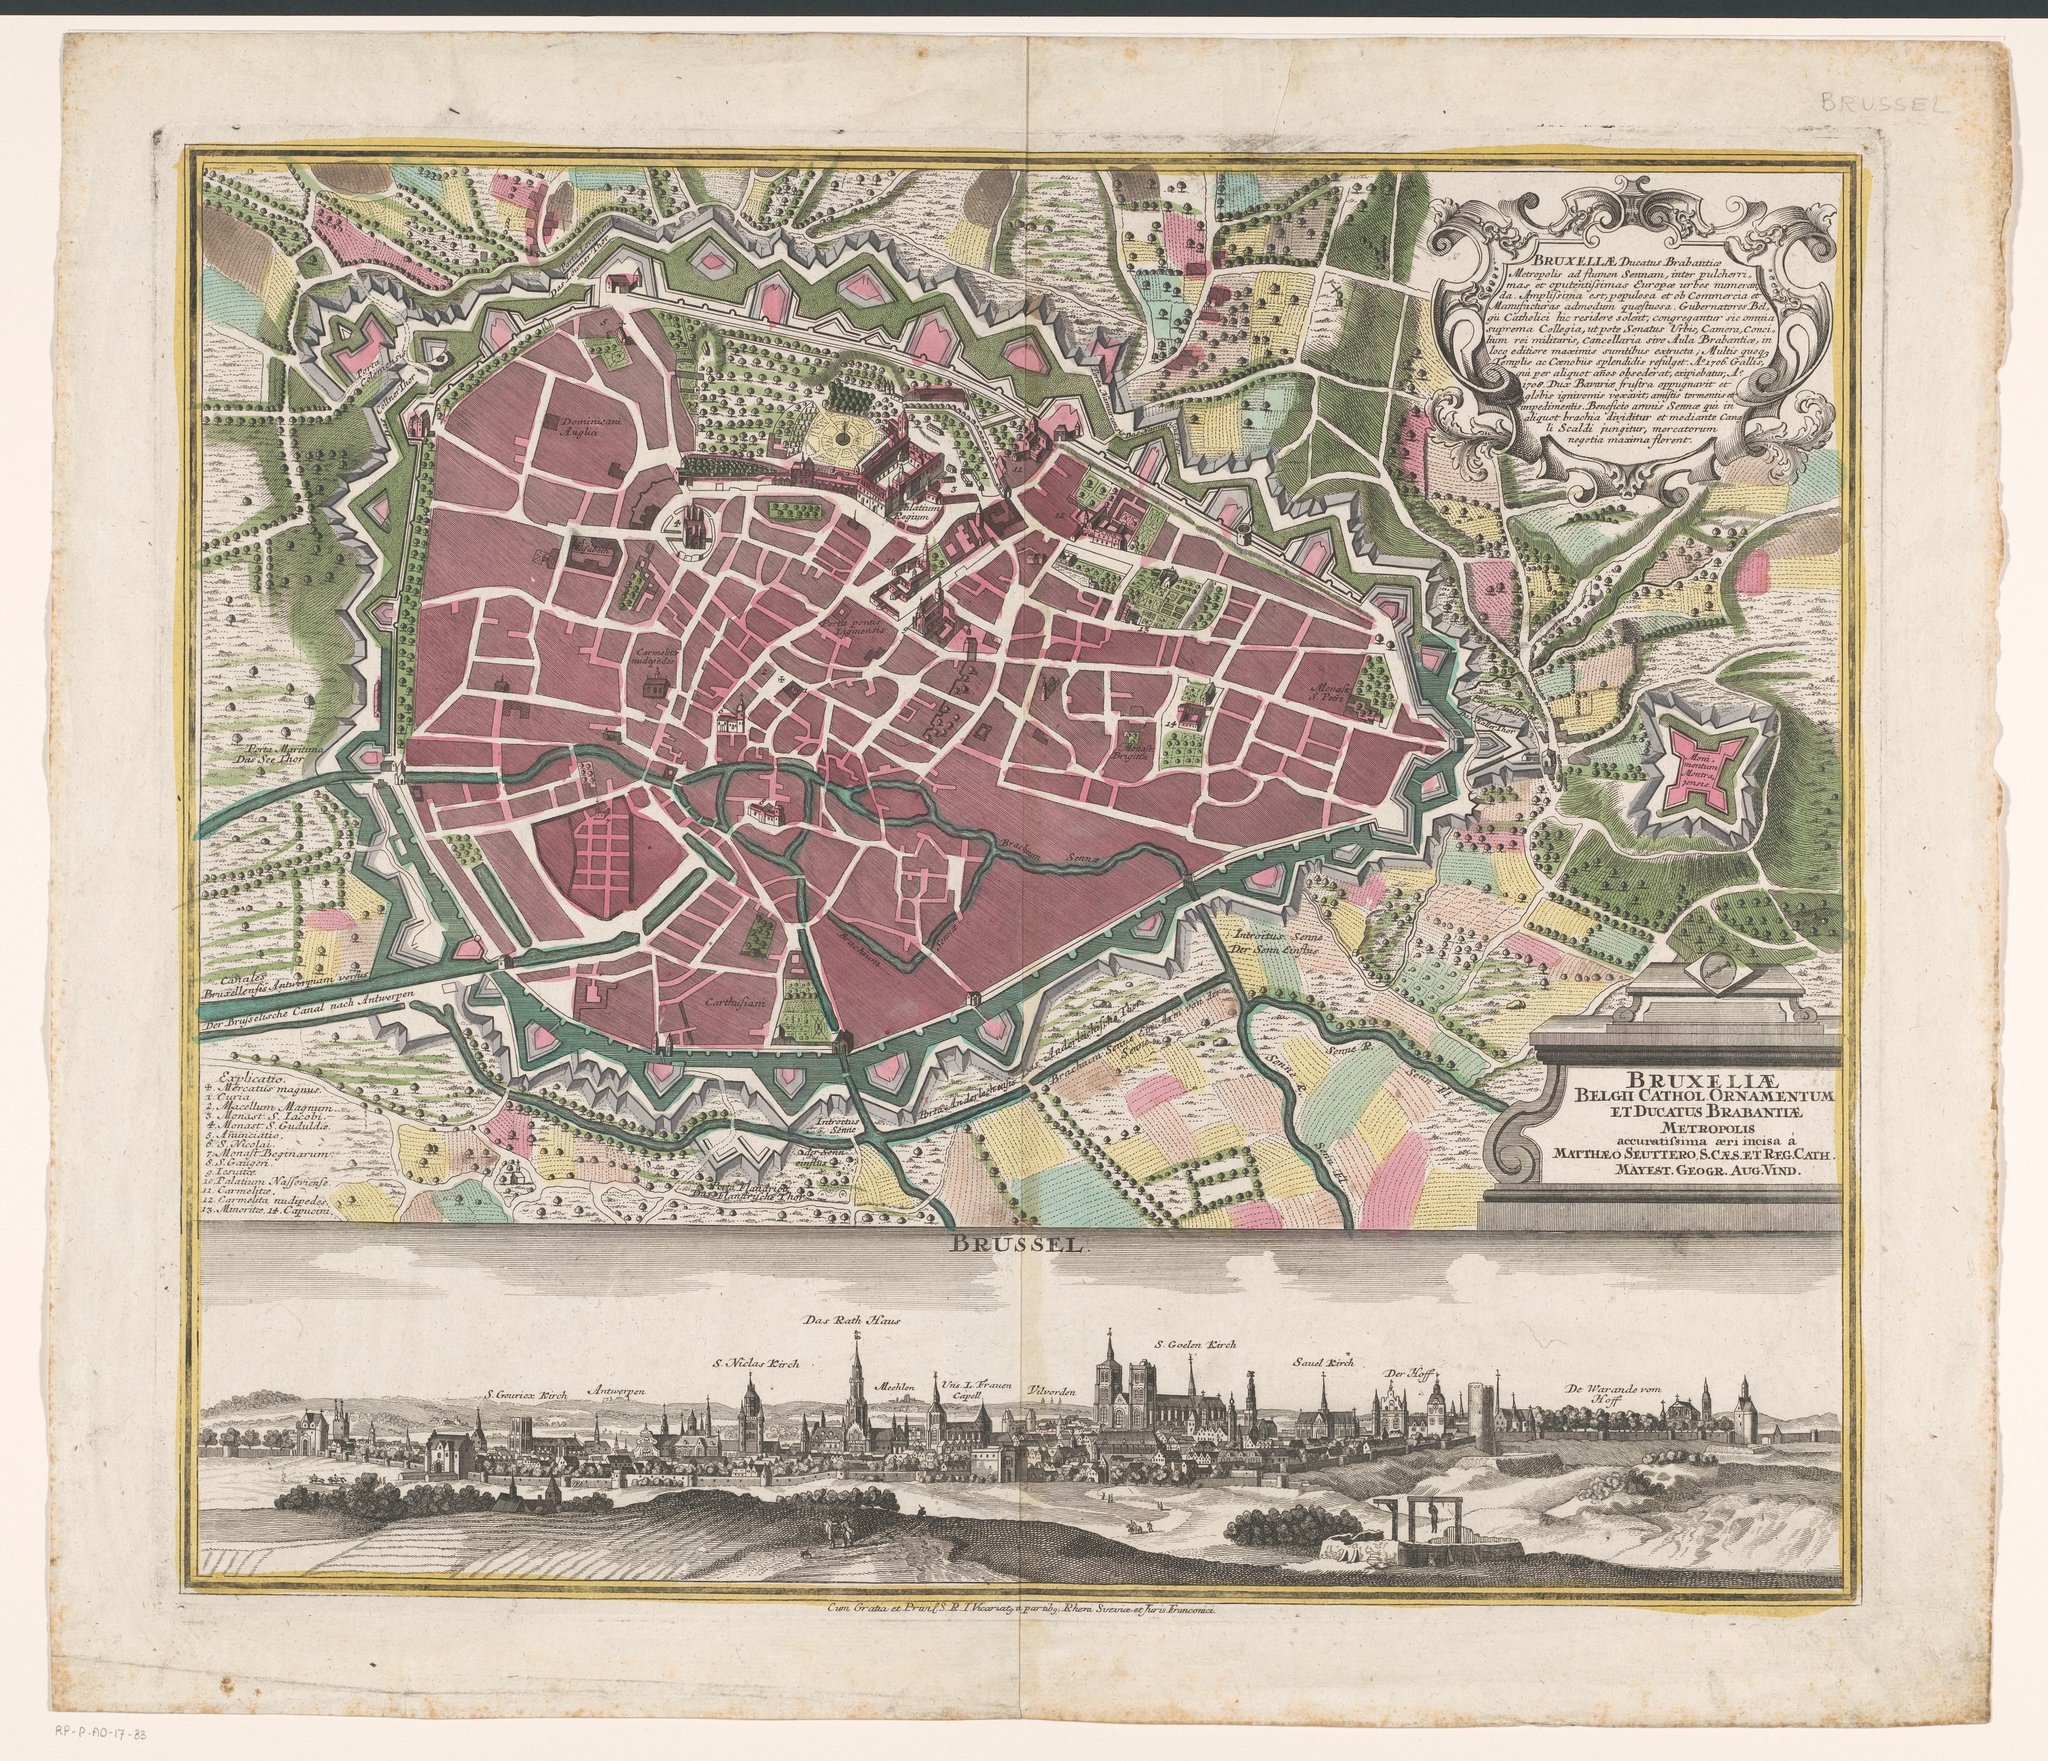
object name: area plan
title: Plattegrond van Brussel met stadsgezicht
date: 1708-1757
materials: paper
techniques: engraving, etching, hand coloring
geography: augsburg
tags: church (exterior), fortified city, maps of cities, prospect of city, town panorama, silhouette of city, brussels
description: Plattegrond van Brussel met gebouwen in vogelvluchtperspectief. Rechtsonder de titelcartouche. Rechtsboven een cartouche met Latijnse tekst. Linksonder een legenda 1-14. Onder de plattegrond een gezicht op Brussel.